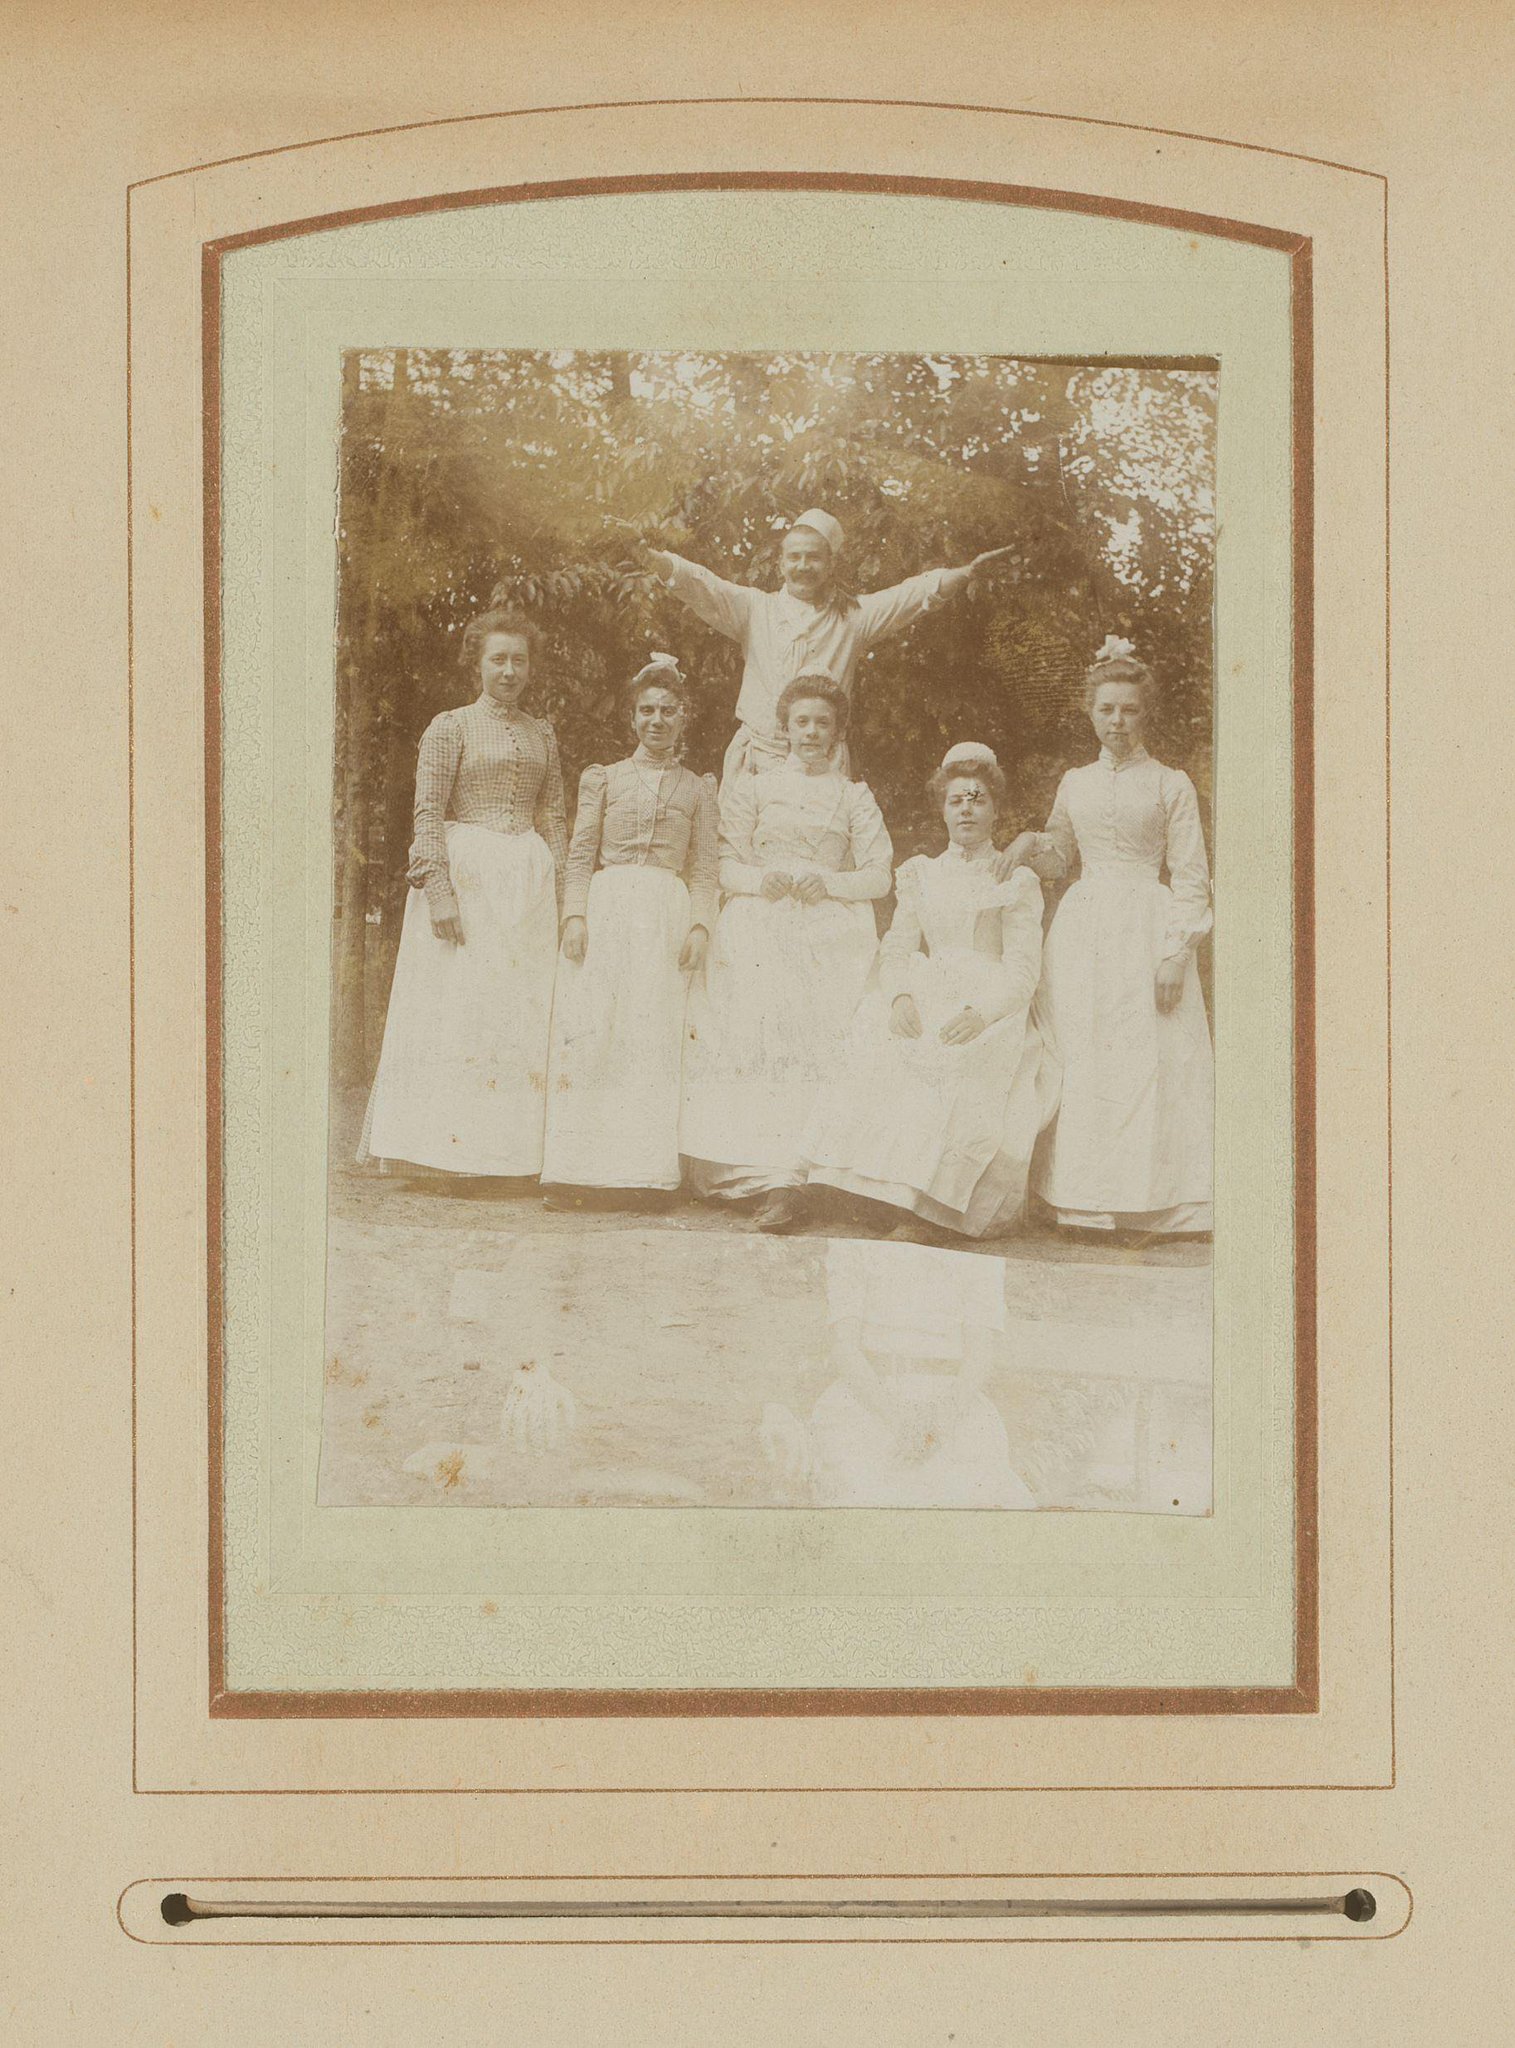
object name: photograph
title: Portret van een man in matrozenpak en vijf jonge vrouwen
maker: Anonymous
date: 1880-1920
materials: cardboard, photographic support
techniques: collodion silver print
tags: historical persons - bb - woman, ensemble of pieces of clothing: sailor suit, adolescent, young woman, maiden (+ five persons), historical persons